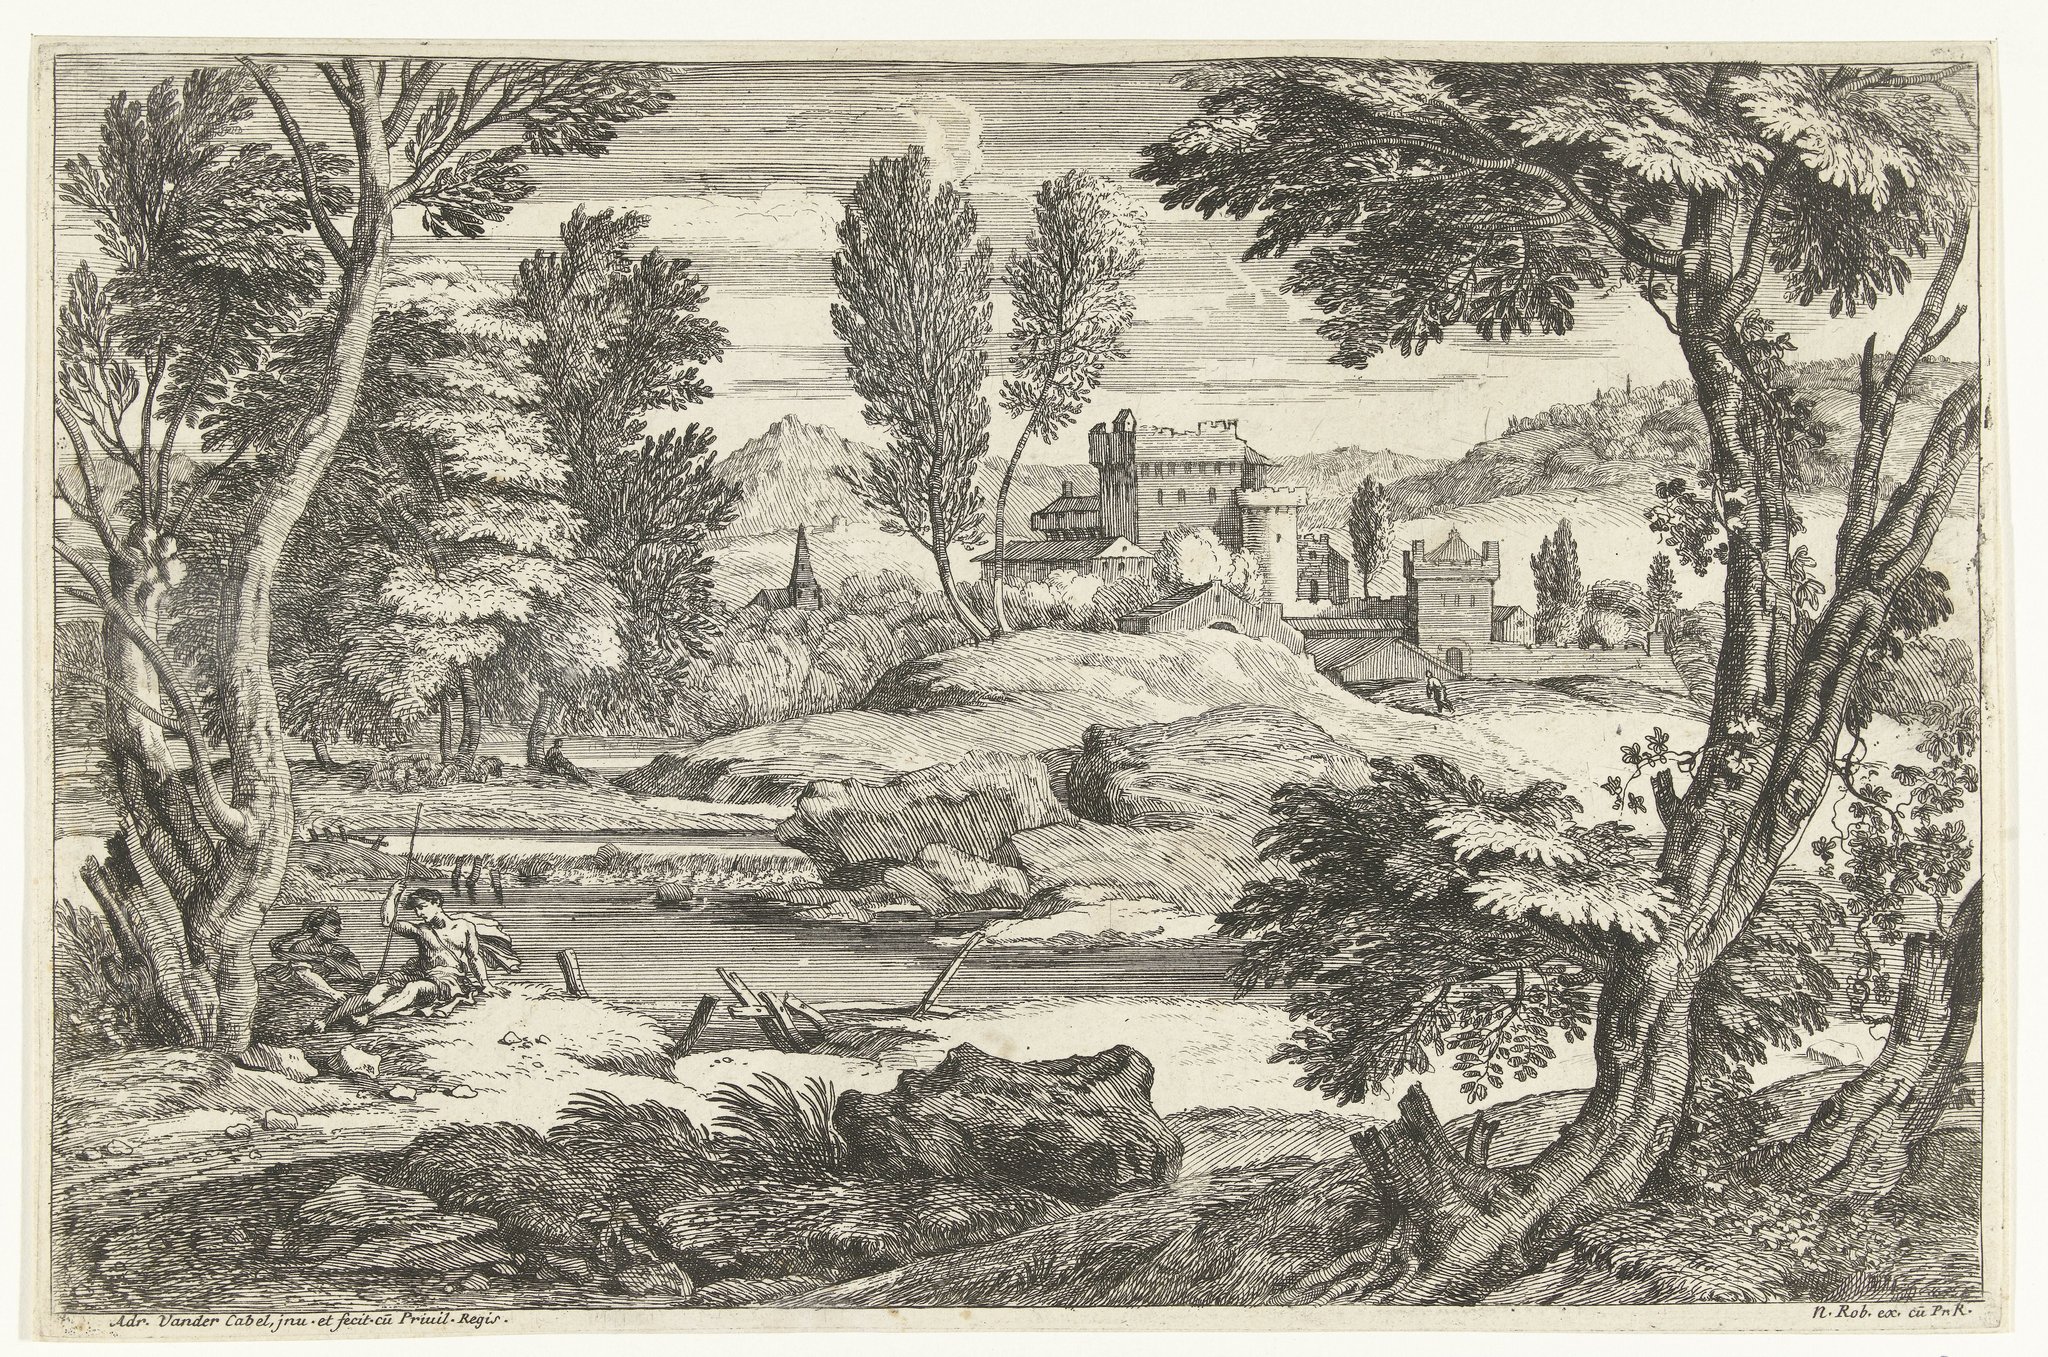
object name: print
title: Landschappen, serie vijf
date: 1648-1705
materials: paper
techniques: etching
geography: france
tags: landscapes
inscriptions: collector's mark: Lugt 240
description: Landschap met gezicht op dorp met drie torens. Op de voorgrond, links, een man met lange stok en wapperende mantel zittend bij vrouw, onder hoge boom. Vierde prent uit de serie van zes.